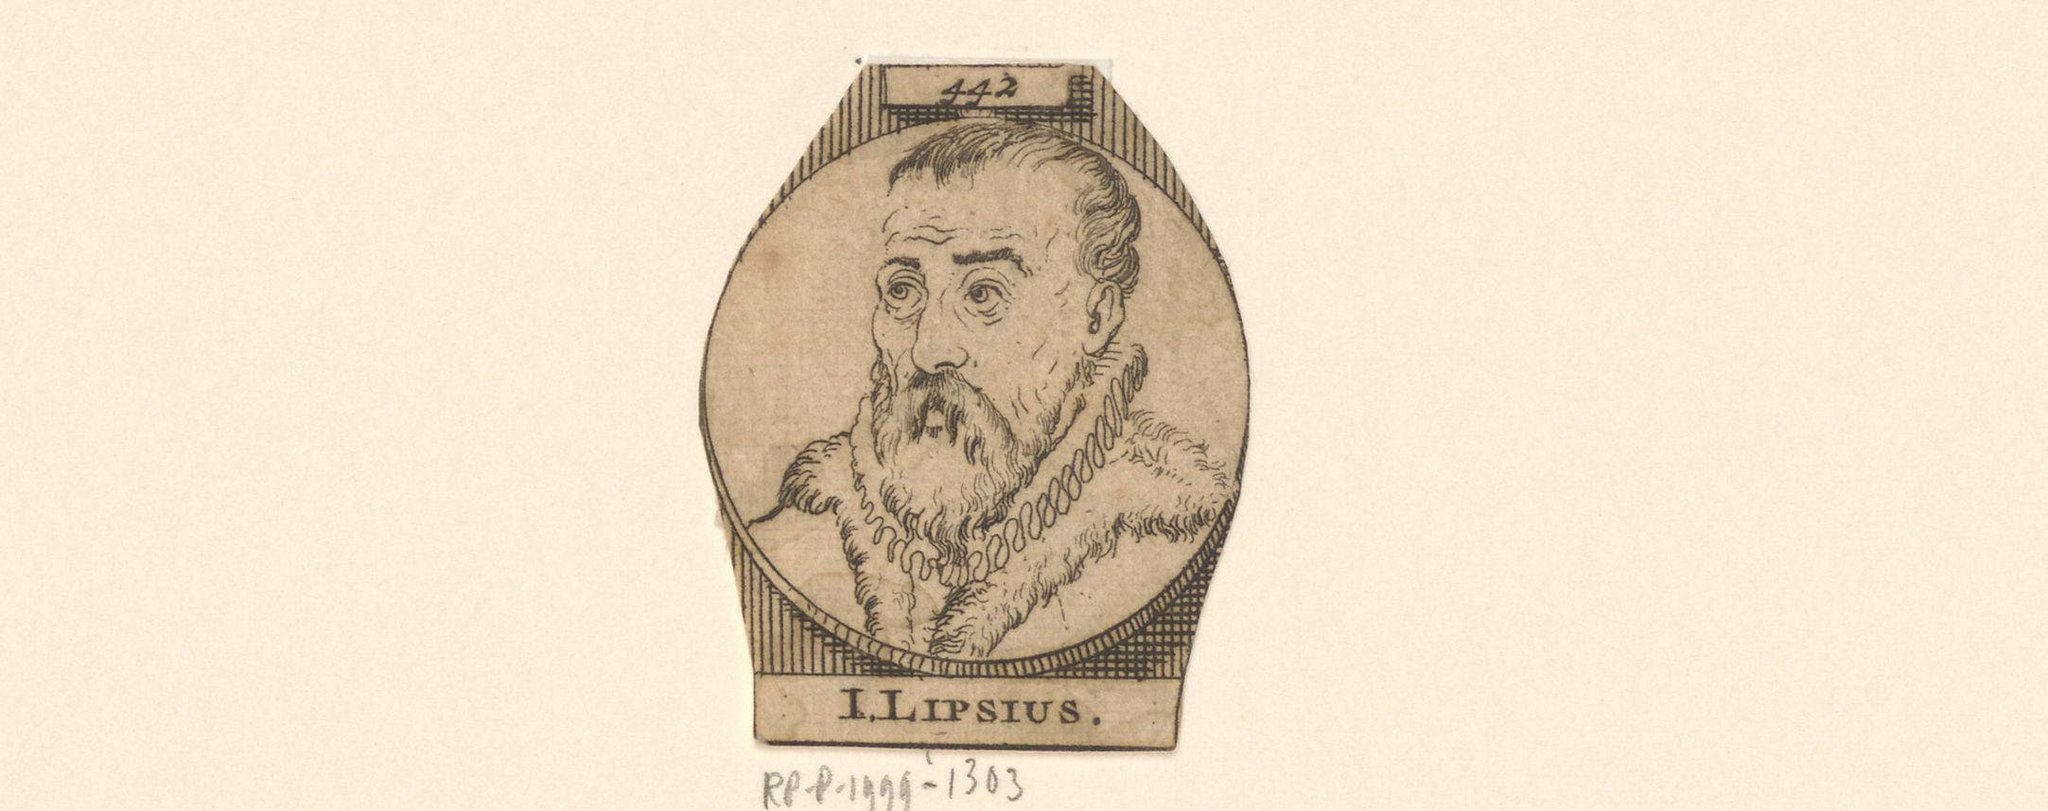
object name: print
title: Portret van Justus Lipsius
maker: Anonymous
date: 1700-1799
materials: paper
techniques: etching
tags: louvain, justus lipsius, historical persons